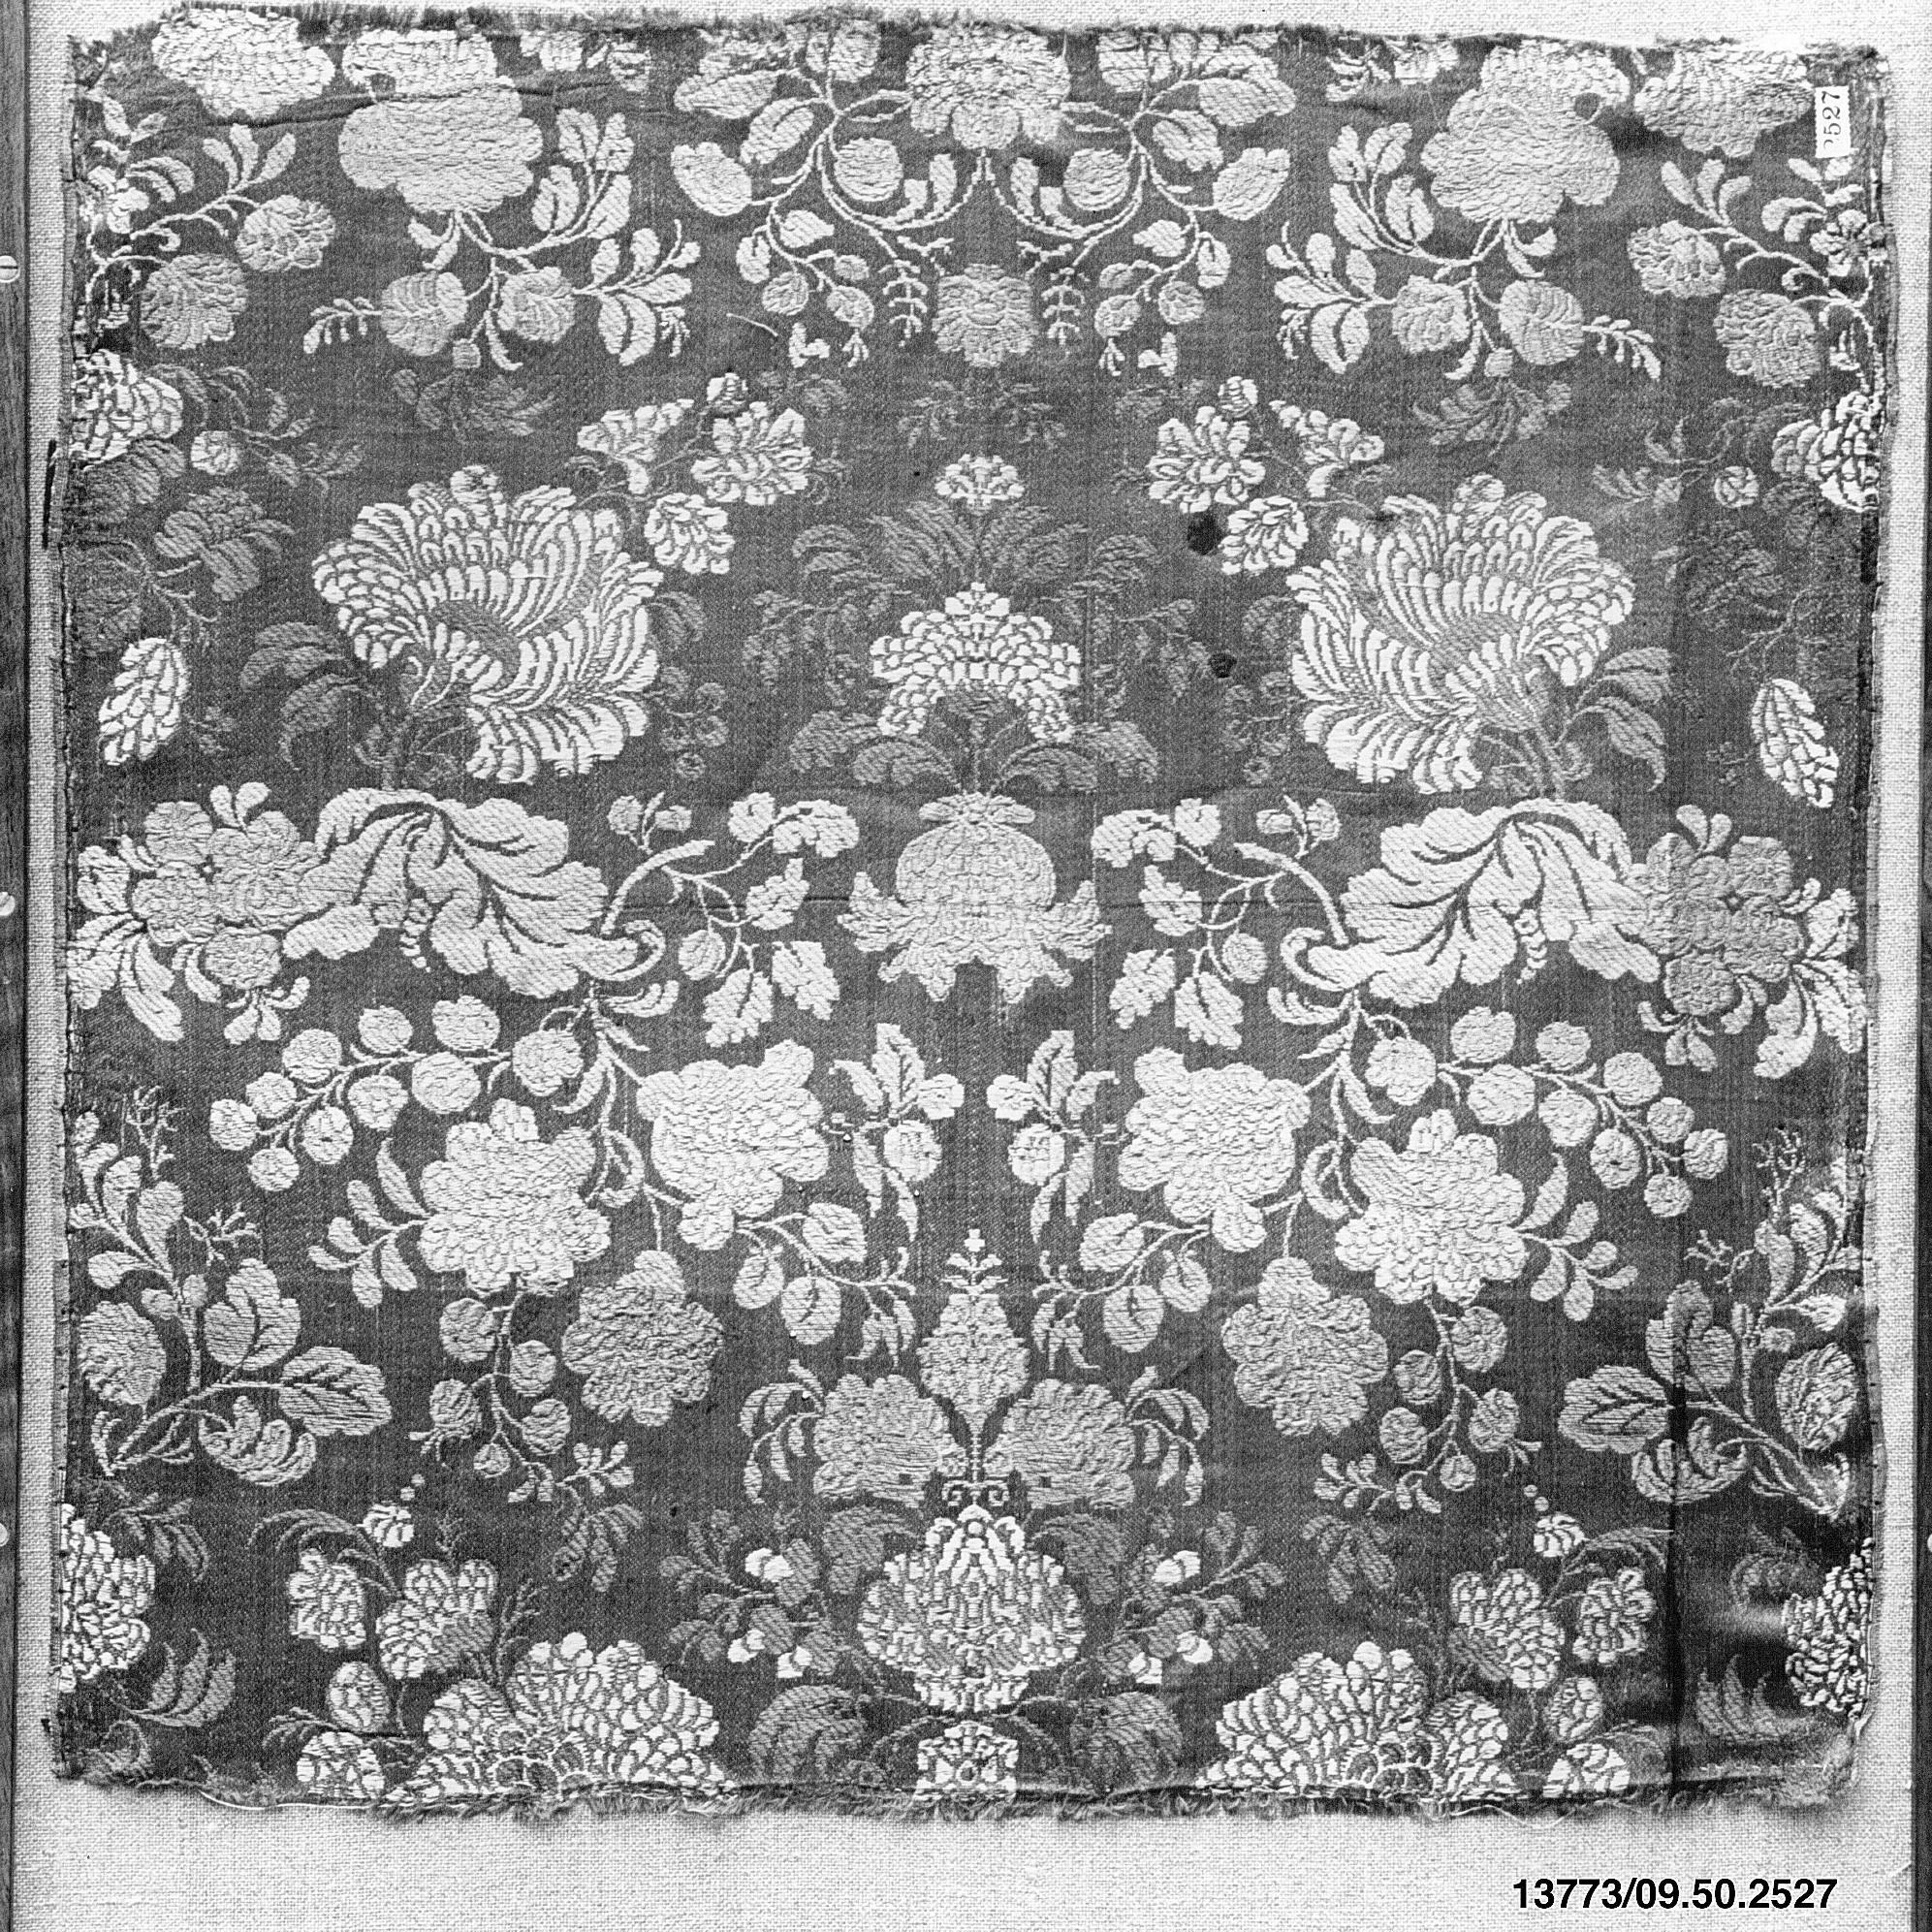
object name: piece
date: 1701-1733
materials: silk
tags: flowers,leaves